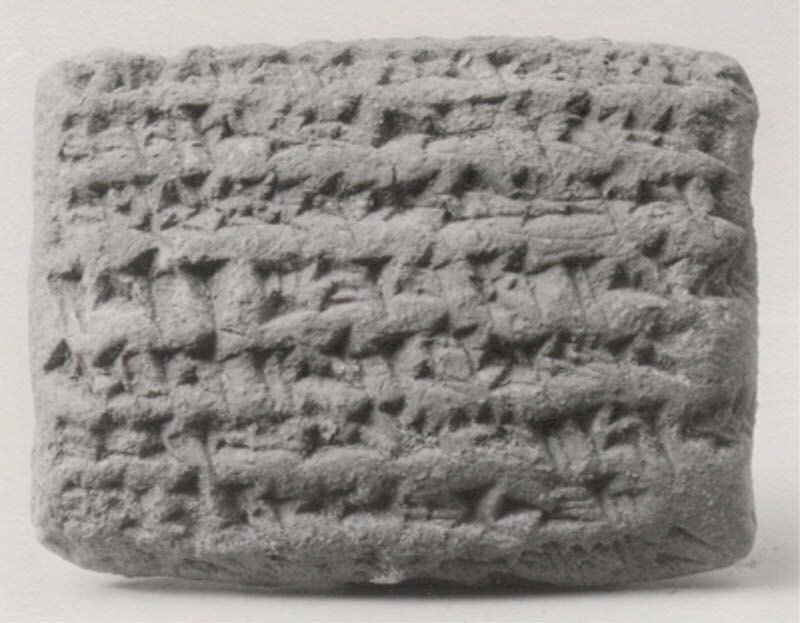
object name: cuneiform tablet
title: Cuneiform tablet: slave sale, Egibi archive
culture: achaemenid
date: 523 BCE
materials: clay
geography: mesopotamia